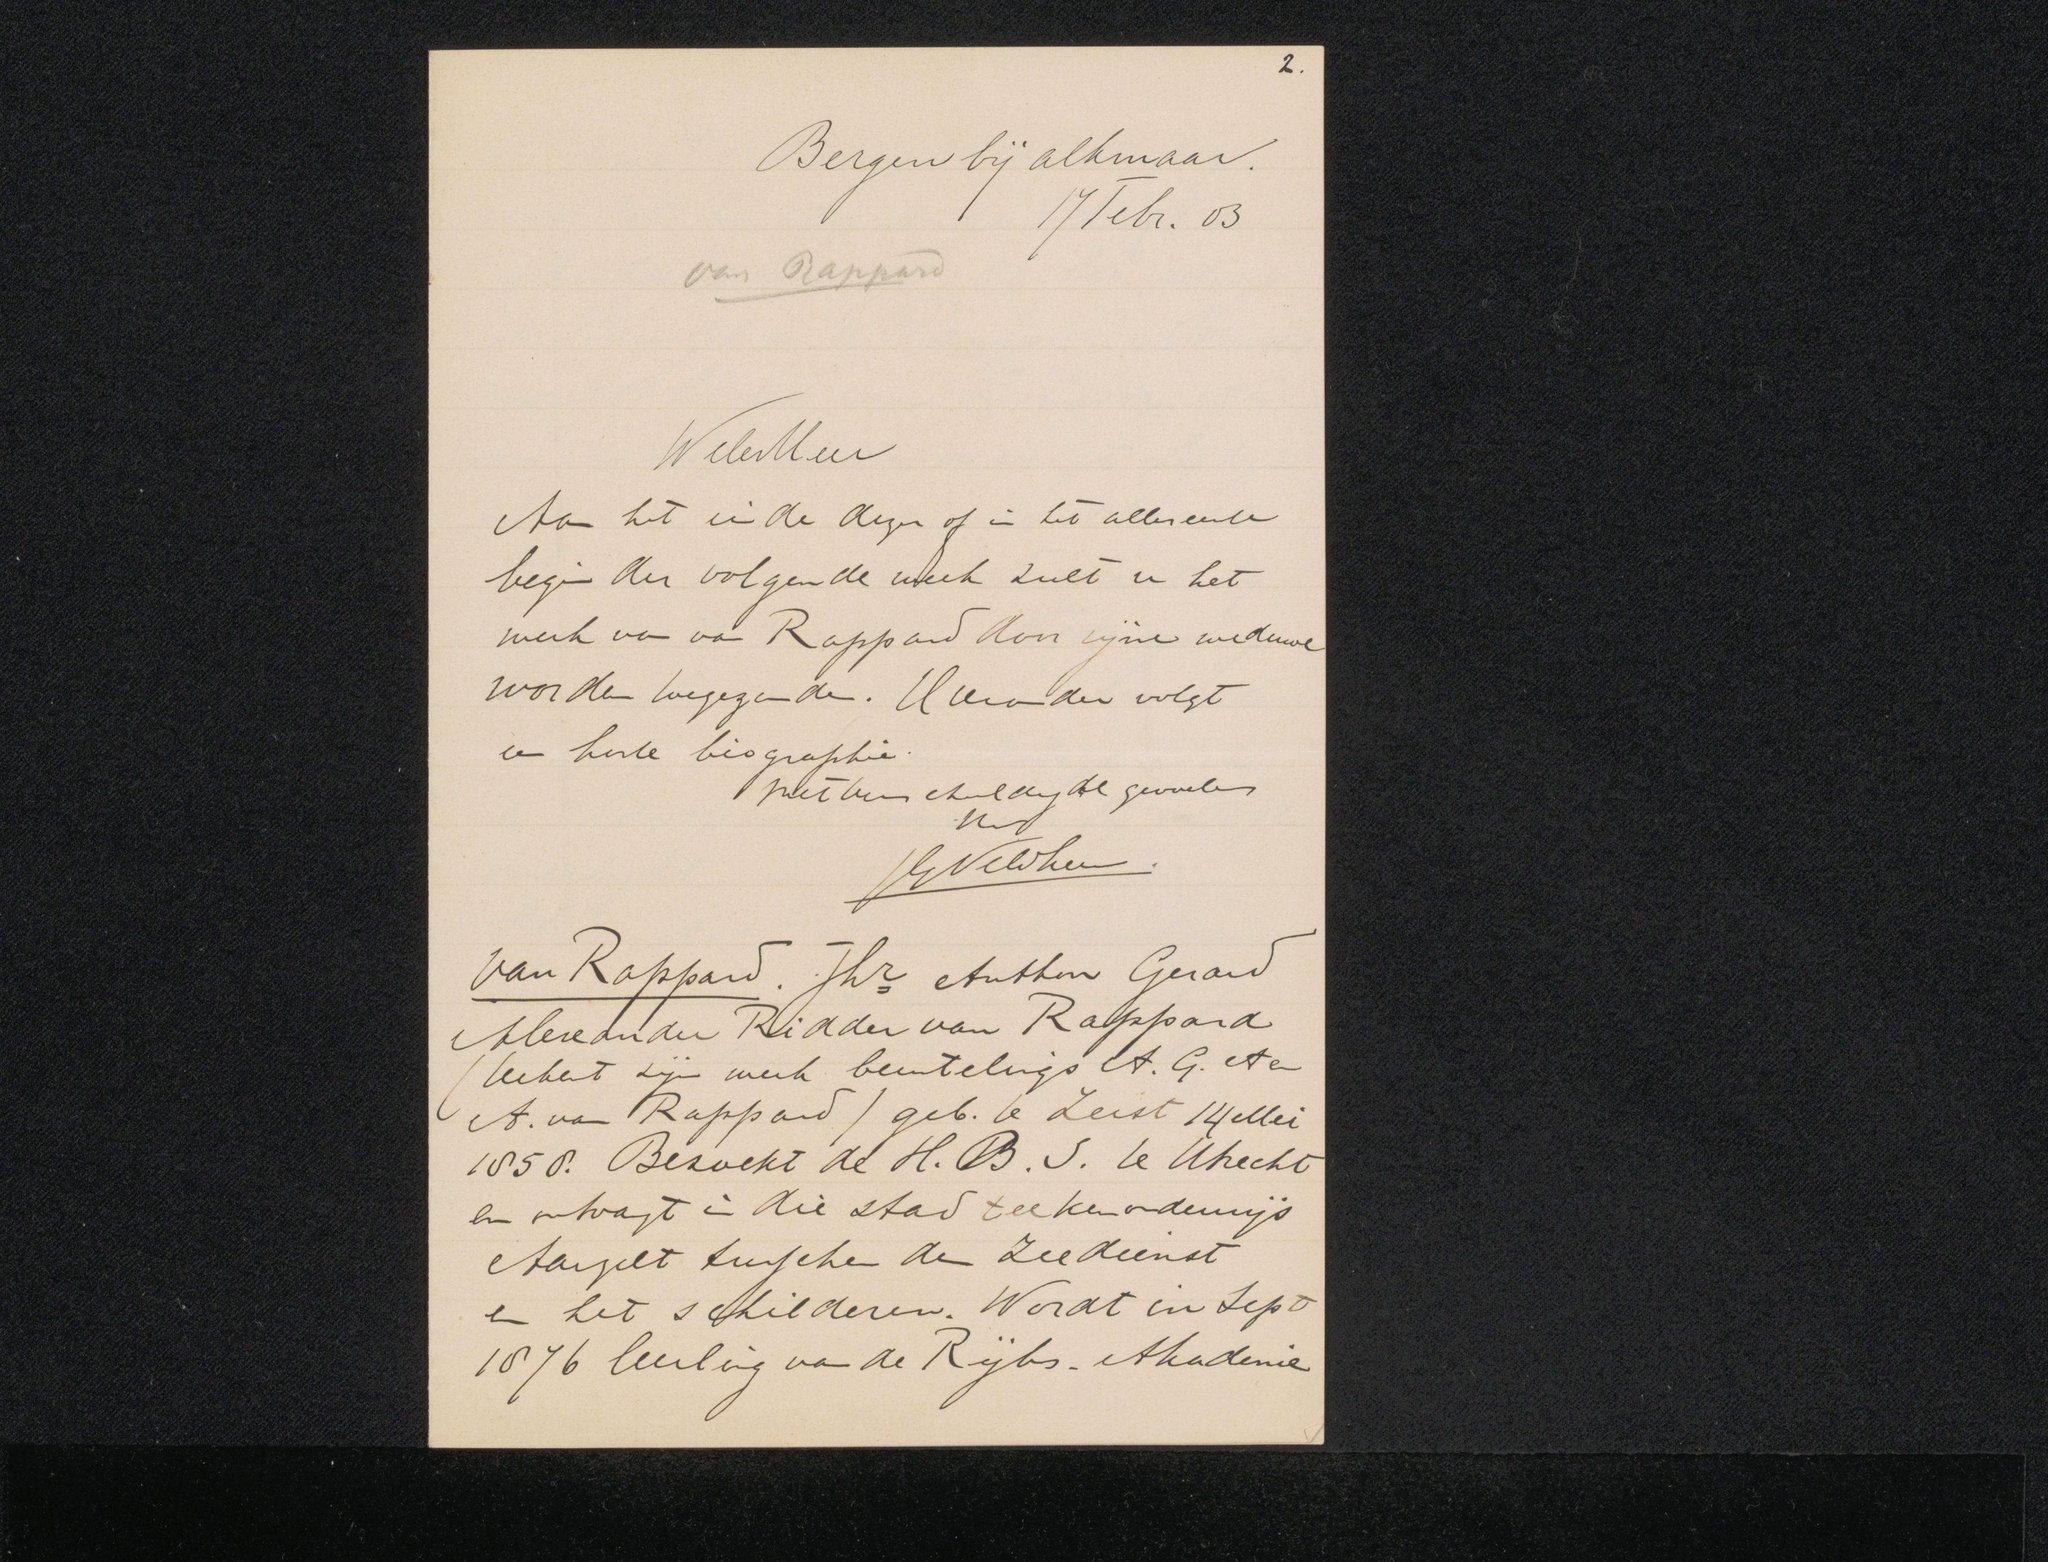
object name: letter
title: Brief aan Pieter Haverkorn van Rijsewijk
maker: jacobus gerardus veldheer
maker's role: draughtsman, print maker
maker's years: 1866-1954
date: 1903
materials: ink, paper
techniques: pen, writing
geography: bergen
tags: zeist, print maker, draughtsman, anthon gerhard alexander van rappard, pieter haverkorn van rijsewijk, education, tuition of the artist (in general), painting (including book-illumination, miniature-painting), diseases, london, brussels, utrecht, paris, amsterdam